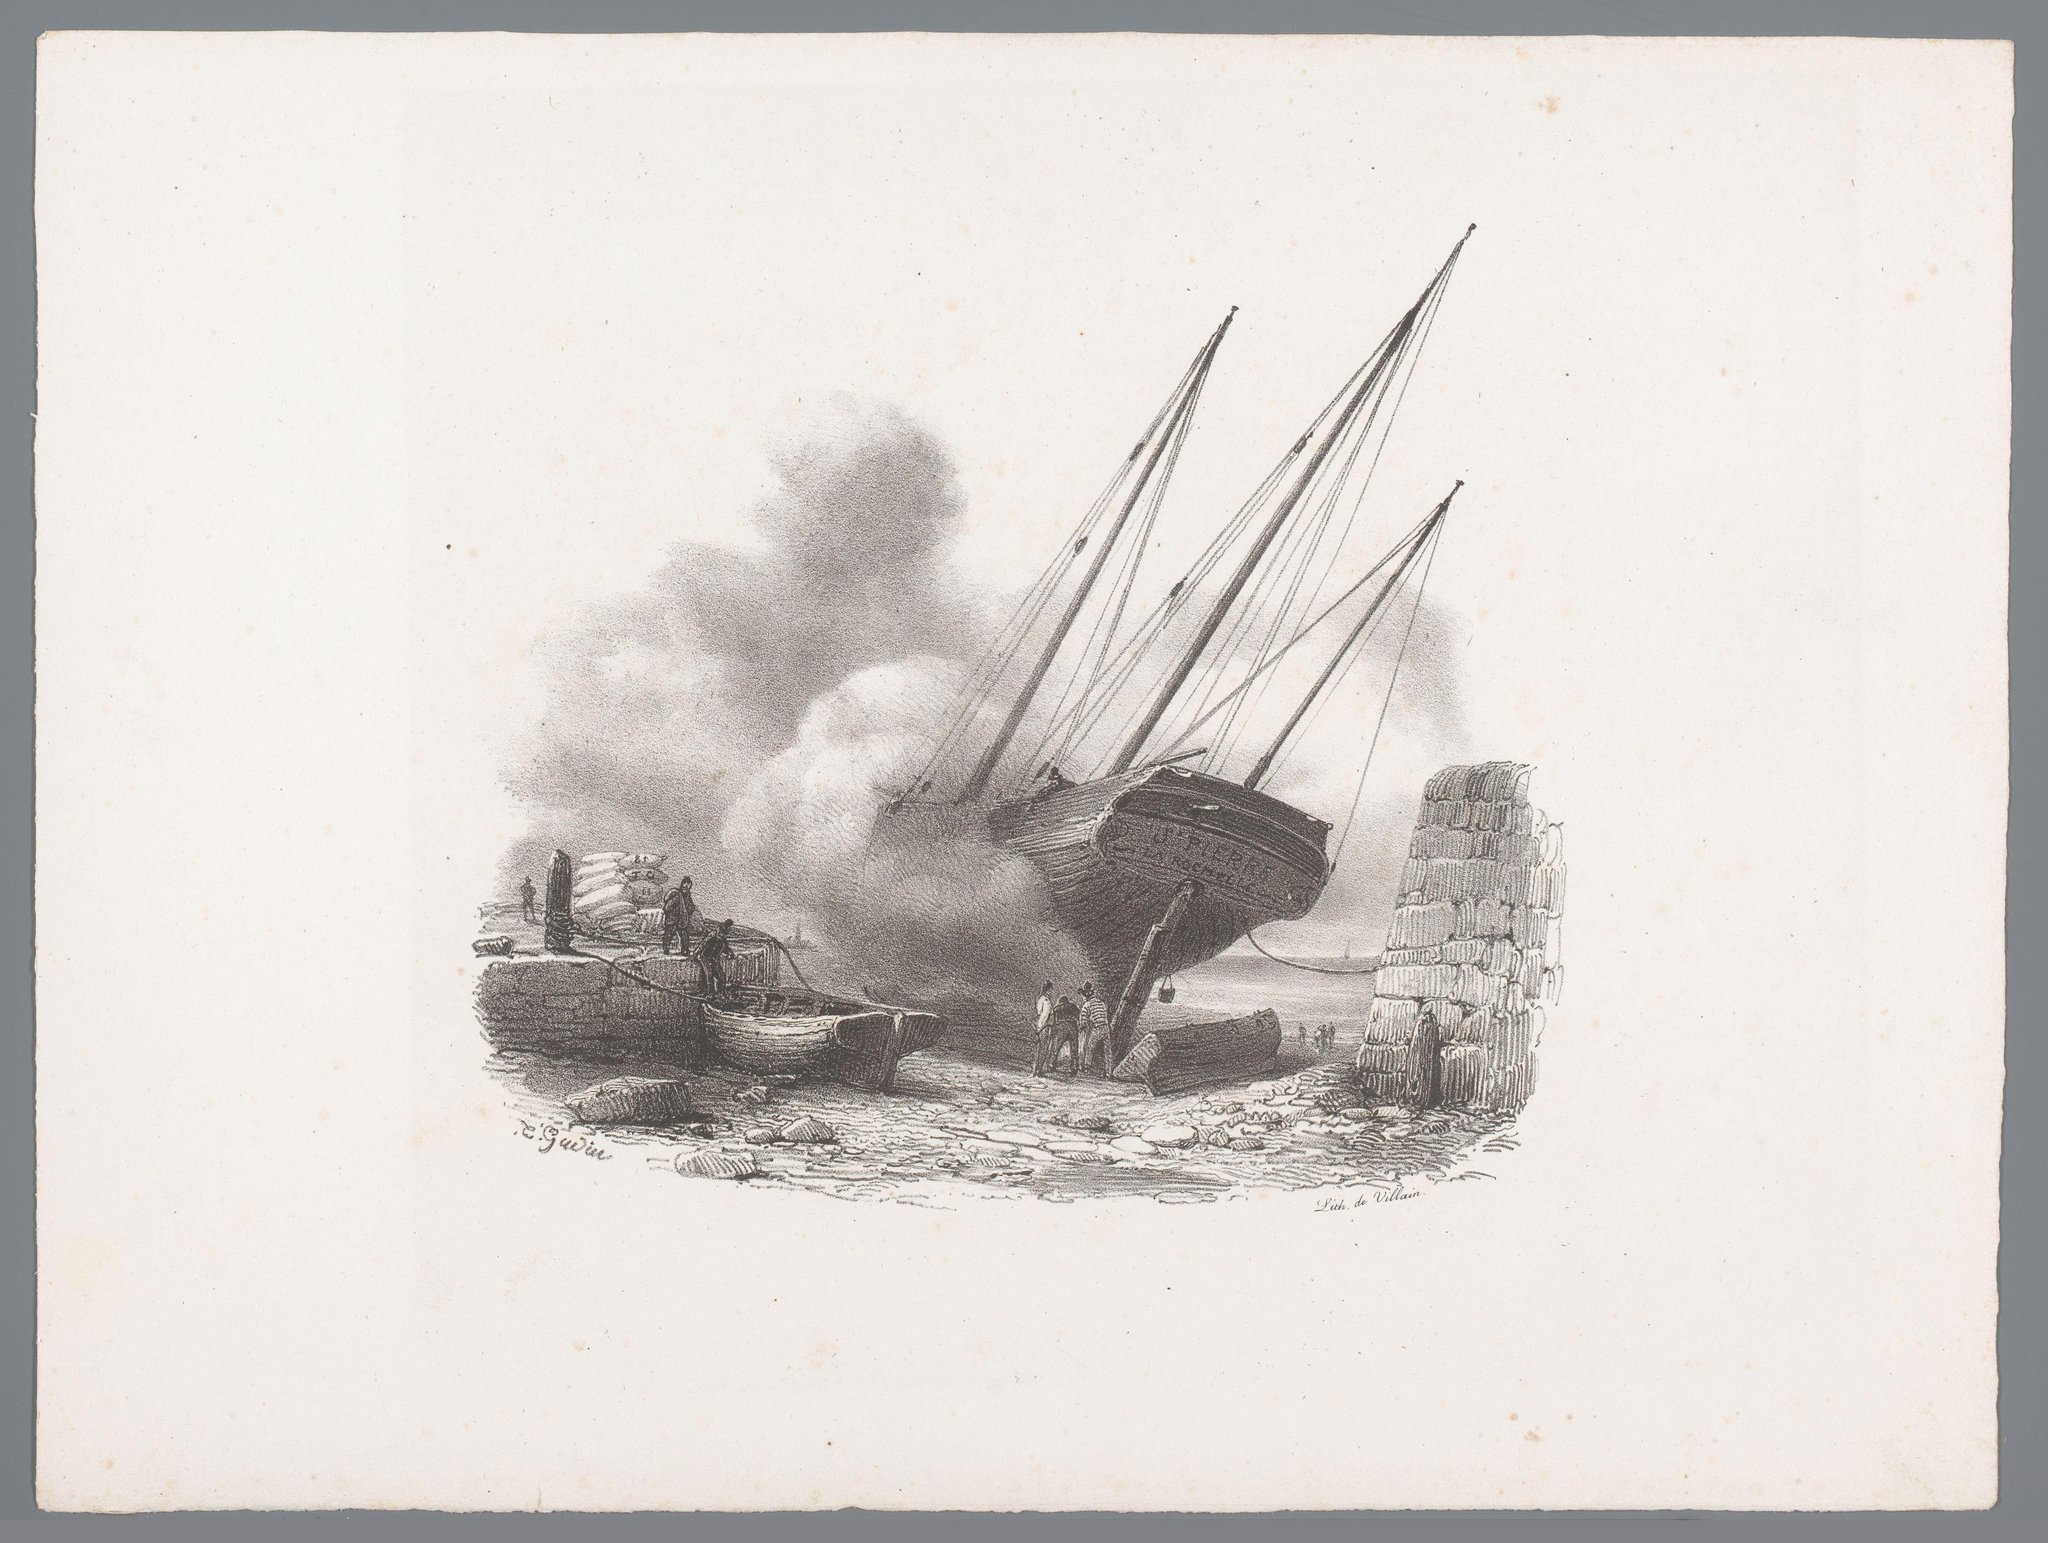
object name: print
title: Zeegezichten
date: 1824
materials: paper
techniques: lithograph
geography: paris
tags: ships (in general), pier, quay, wharf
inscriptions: collector's mark: Lugt 2228a